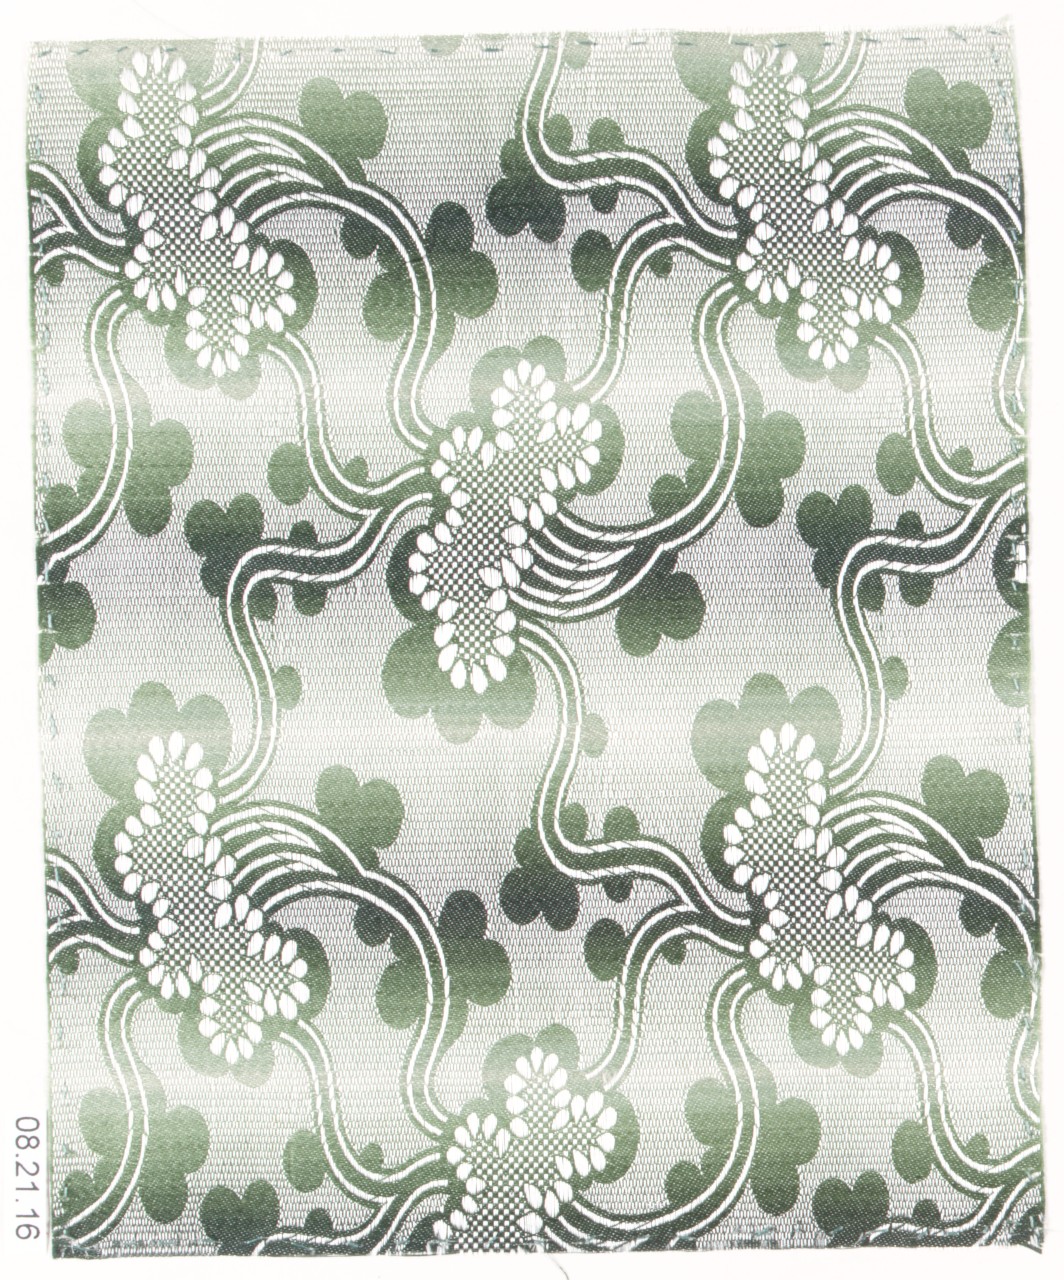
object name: textile sample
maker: Anonymous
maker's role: designer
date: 1900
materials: silk